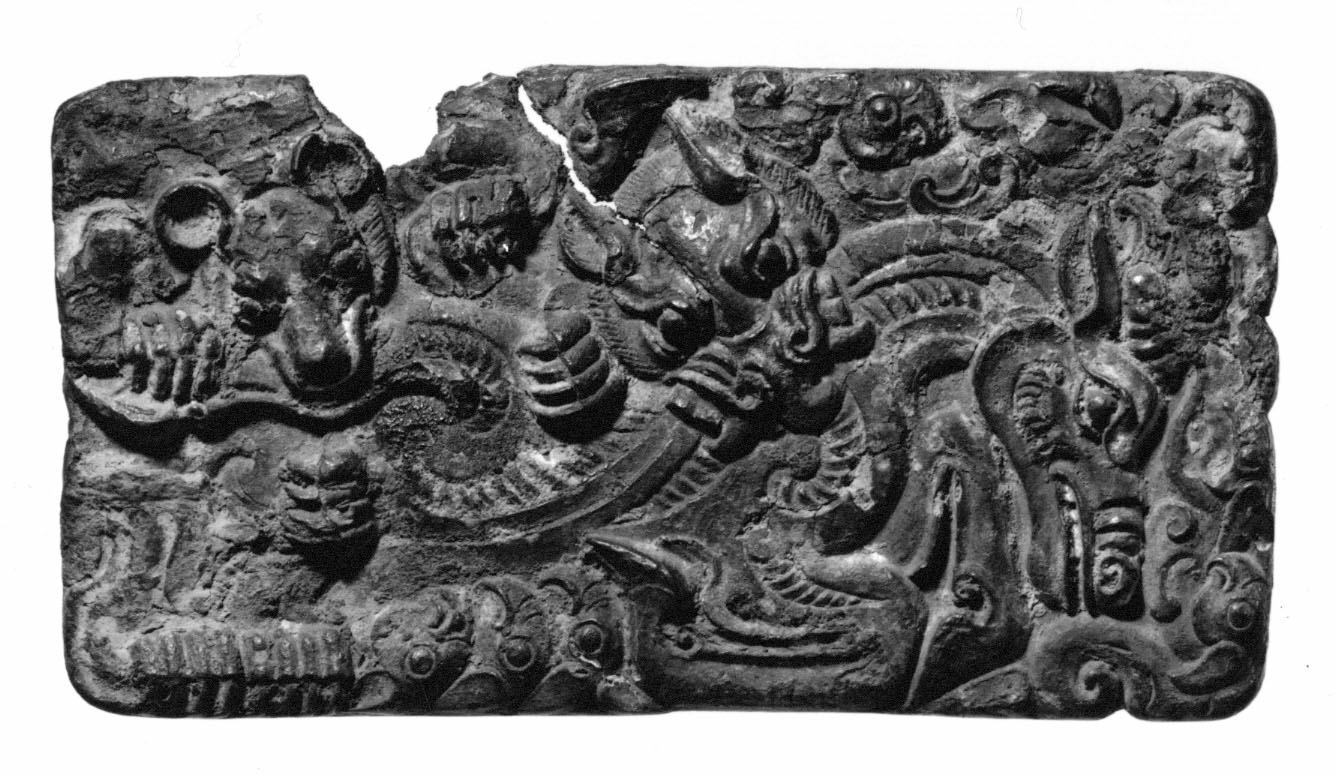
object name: belt buckle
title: Belt Buckle with Animal-Combat Scene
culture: north chinese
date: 300-101 BCE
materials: bronze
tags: animals